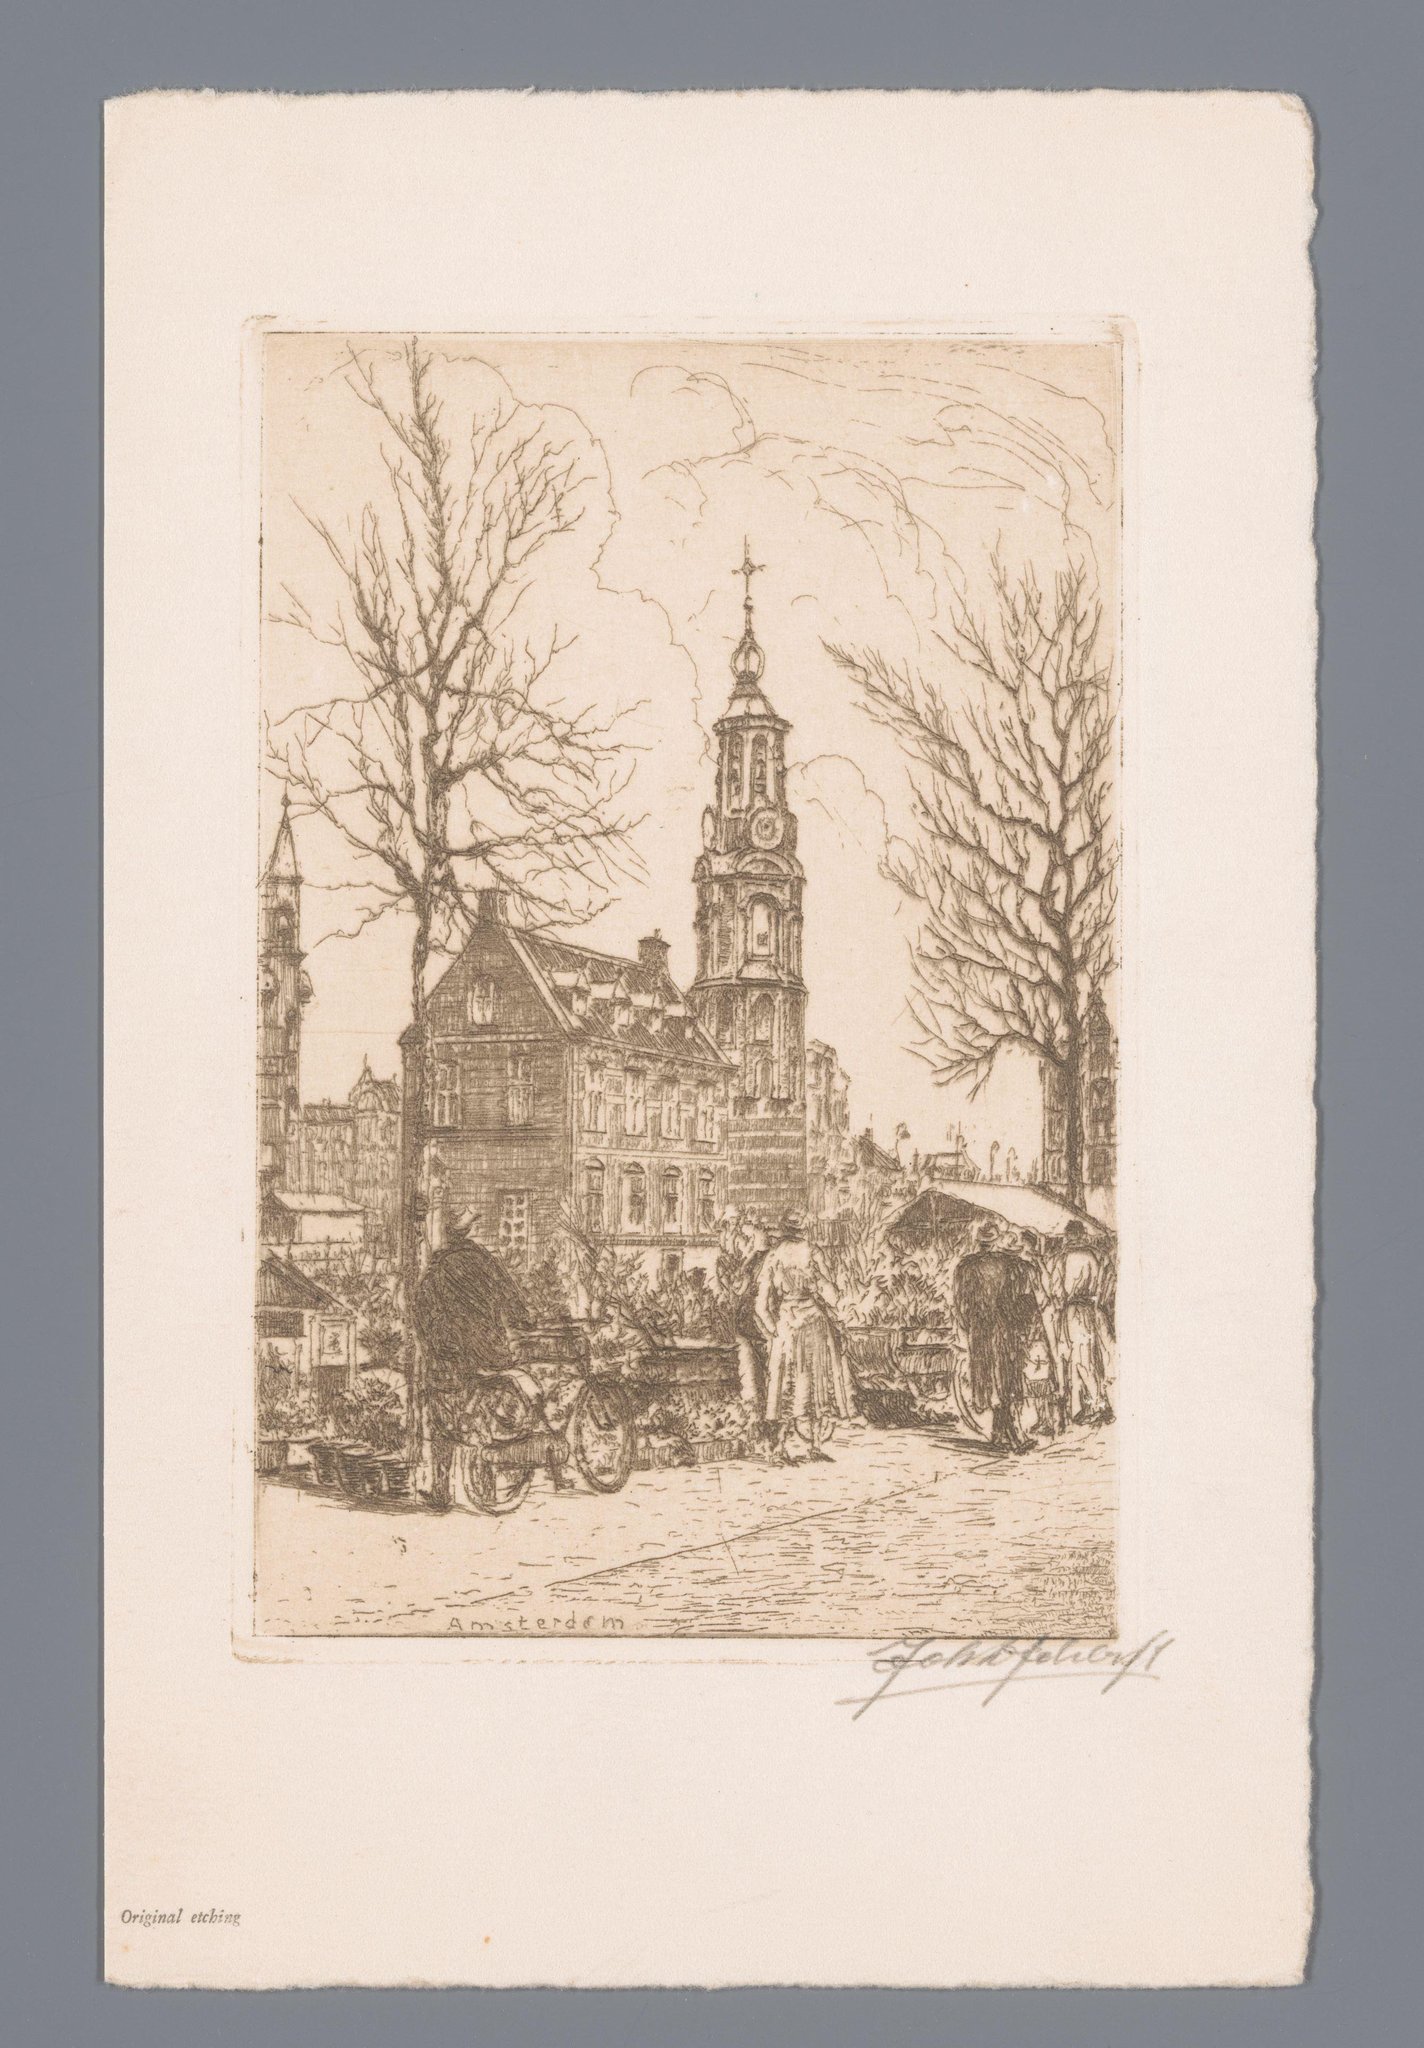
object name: print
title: Gezicht op de Munttoren vanaf de bloemenmarkt op het Singel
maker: johannes d. scherft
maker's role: print maker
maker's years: 1891-1969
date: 1901-1969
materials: paper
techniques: drypoint, etching, intaglio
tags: tower, clock tower ~ monumental adornment, stall, booth (~ market), bicycle